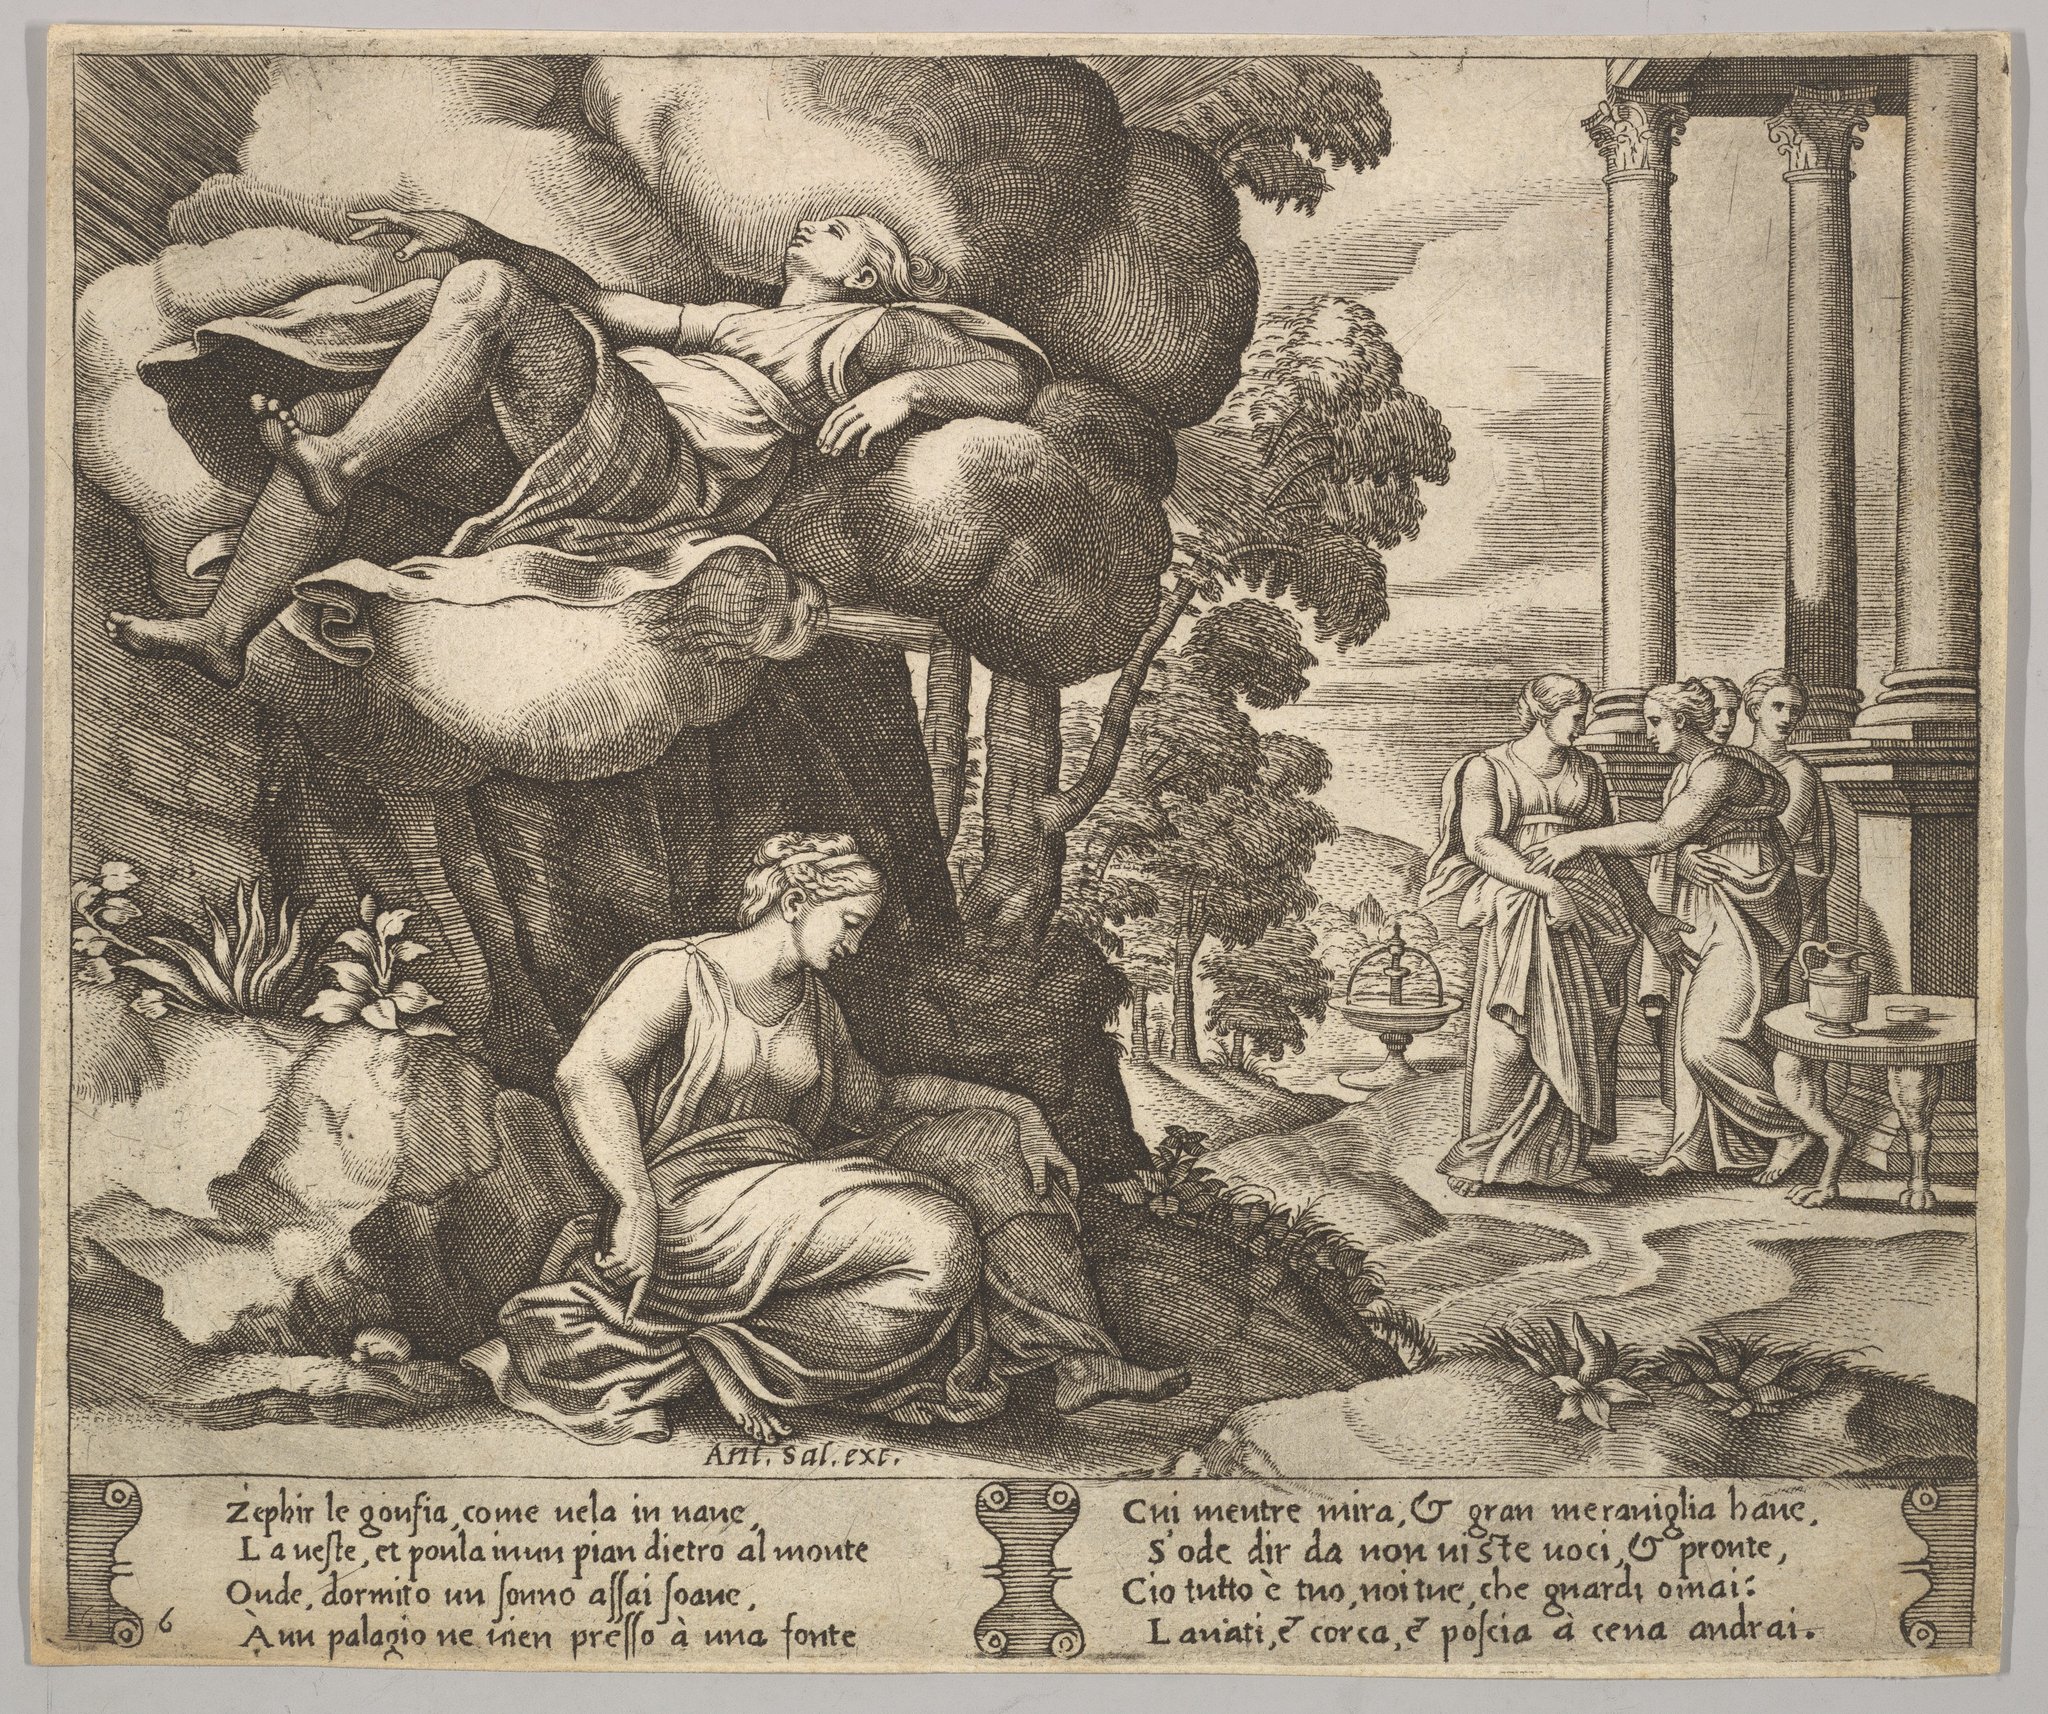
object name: print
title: Plate 6: Zephir carrying off Psyche to an enchanted palace, from "The Fable of Psyche"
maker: master of the die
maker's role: artist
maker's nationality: italian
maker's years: 1525-1560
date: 1530-1560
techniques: engraving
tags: women,psyche